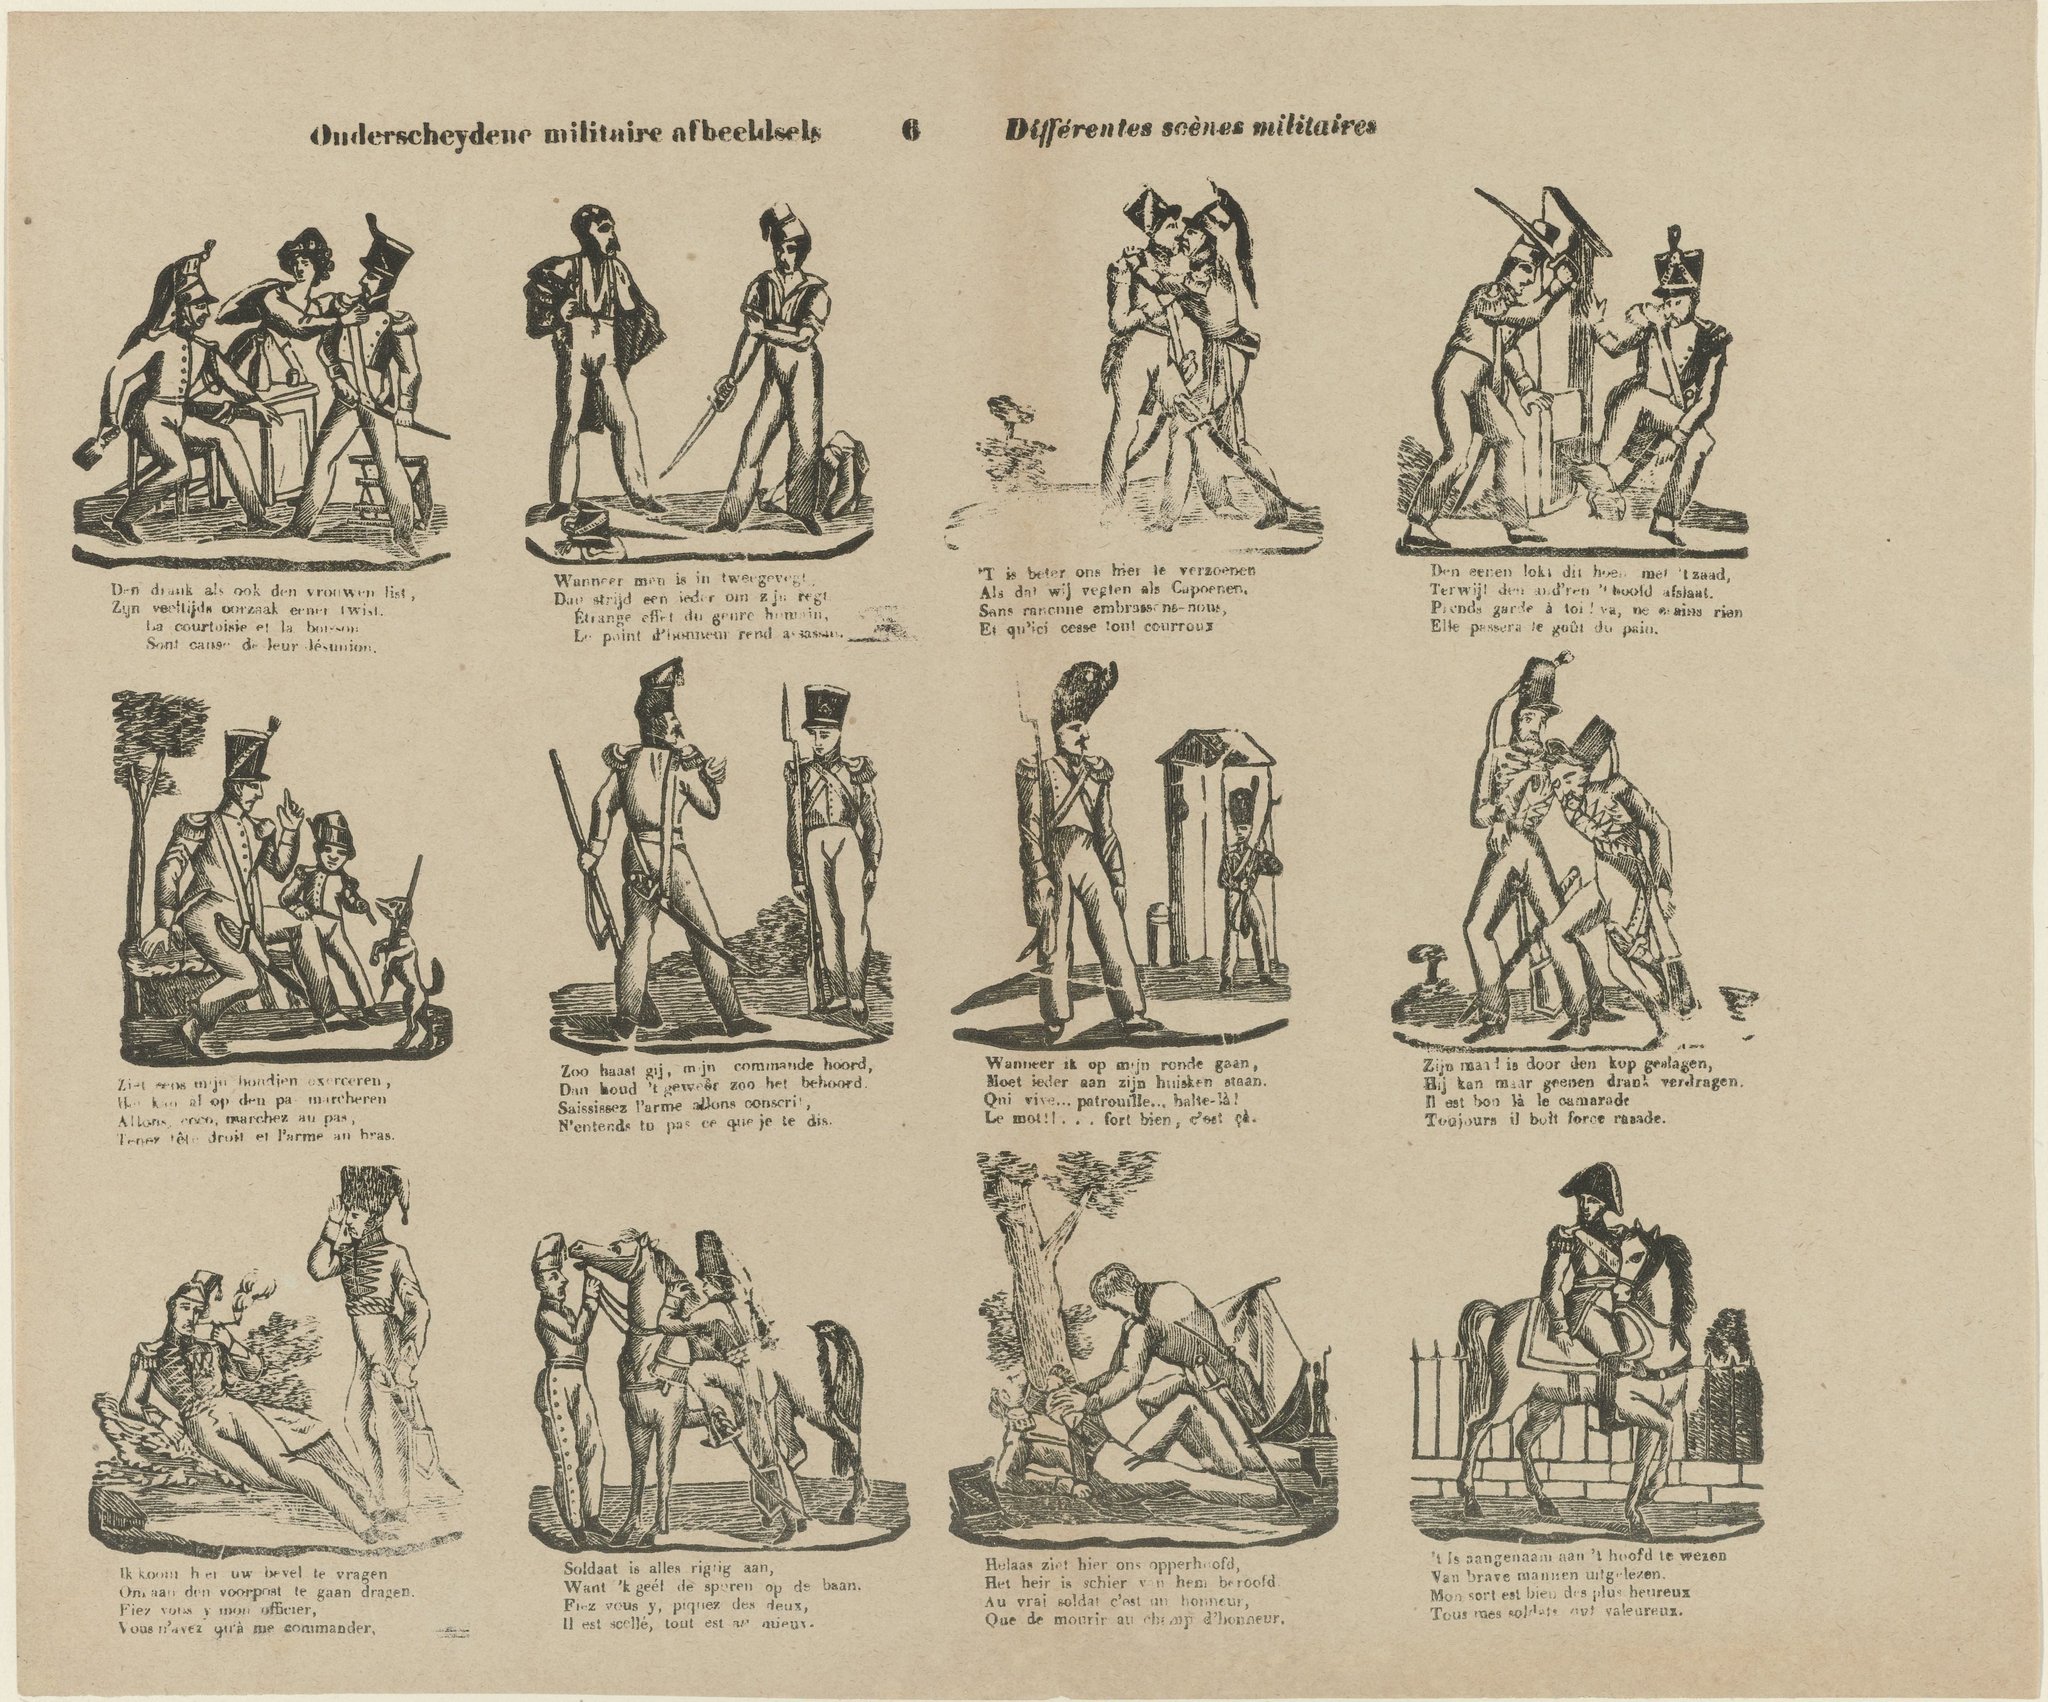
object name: print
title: Onderscheydene militaire afbeeldsels / Différentes scènes militaires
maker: Anonymous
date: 1833-1856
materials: paper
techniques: letterpress printing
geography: turnhout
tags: the soldier; the soldier's life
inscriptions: collector's mark: Lugt 2760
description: Blad met 12 voorstellingen over het leven van militairen. Onder elke voorstelling een tweeregelig vers in het Nederlands en in het Frans. Genummerd midden boven: 6.